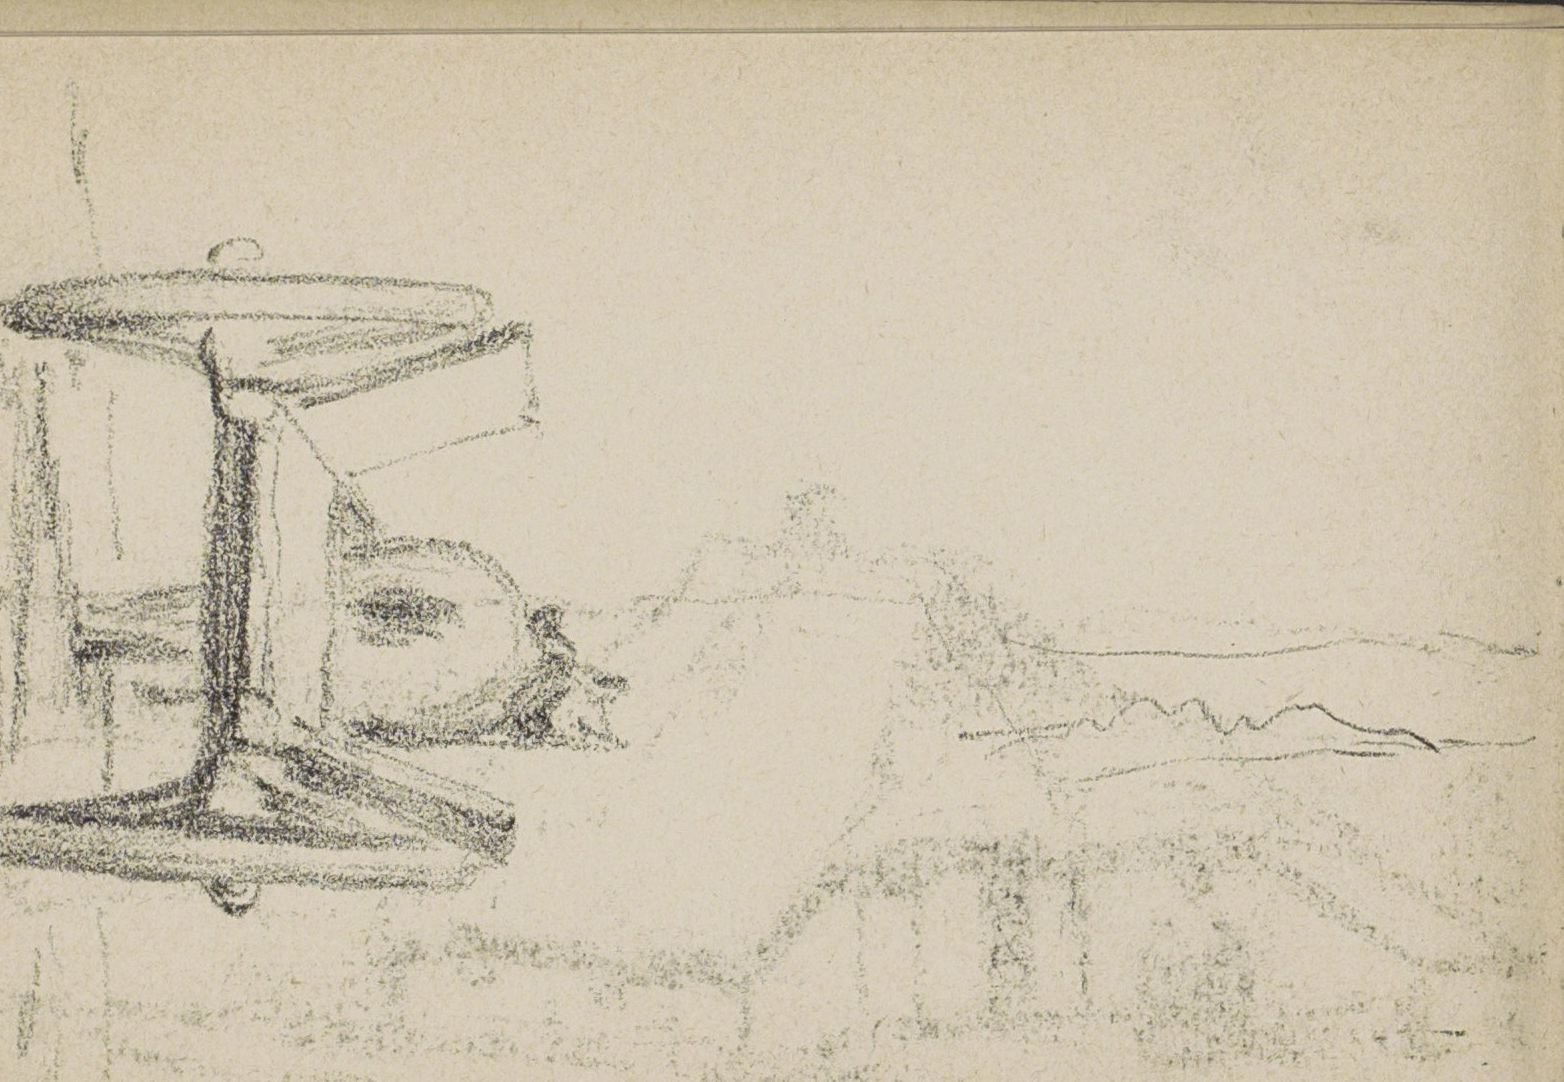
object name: sketchbook leaf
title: Paardenkar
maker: willem cornelis rip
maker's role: draughtsman, painter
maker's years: 1856-1922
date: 1896-1897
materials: chalk, paper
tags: animal traction, animal-drawn vehicle (carriage etc.)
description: Blad 26 verso uit een schetsboek met 44 bladen.